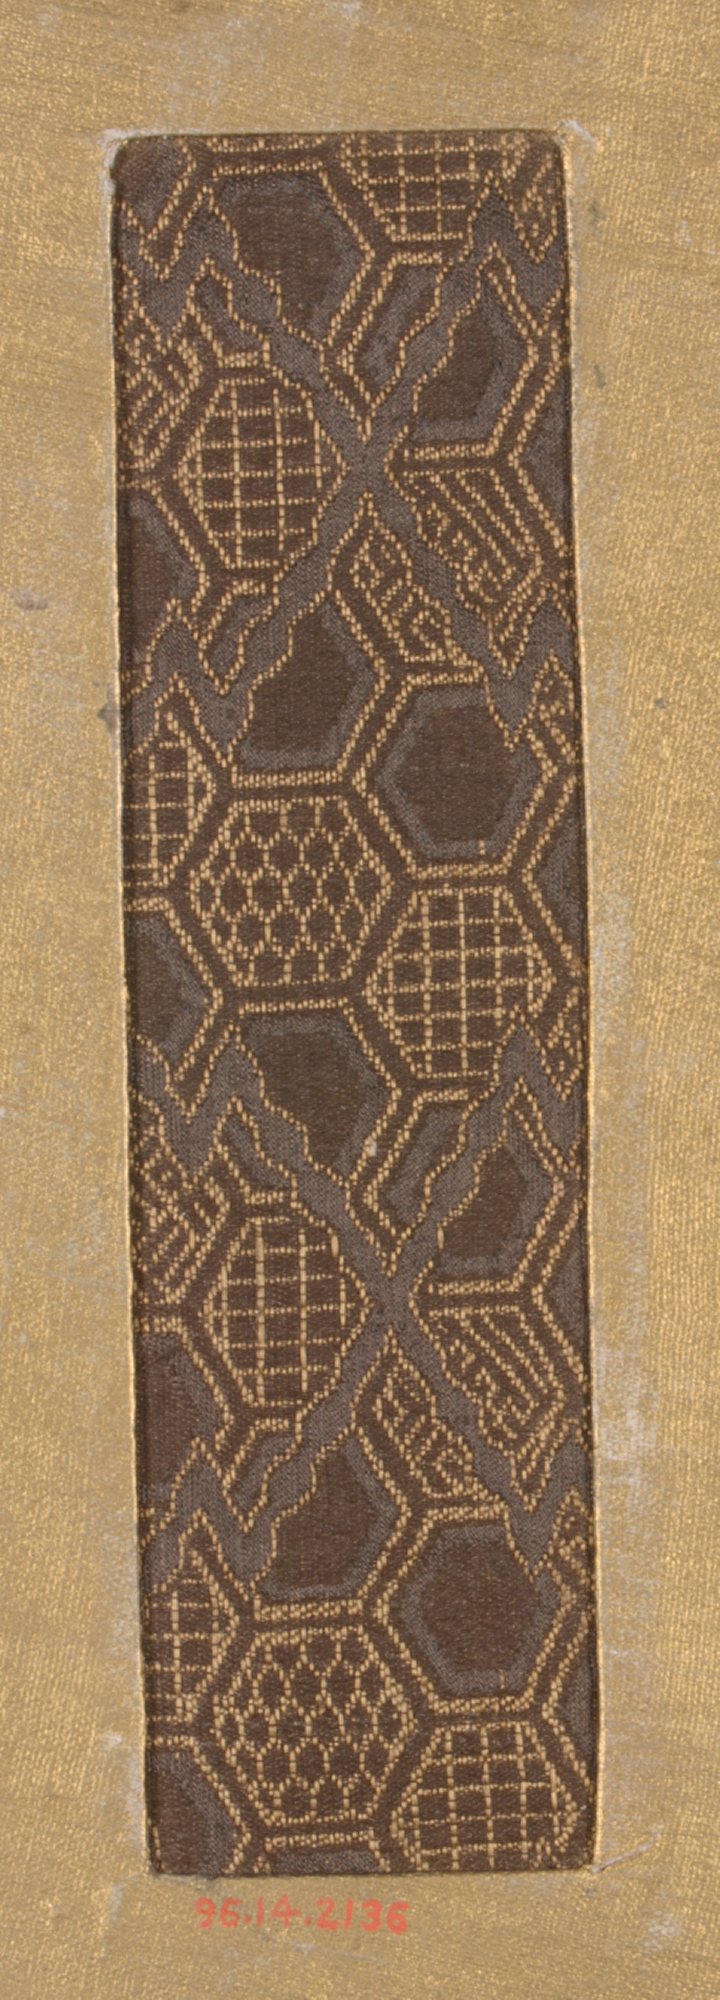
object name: piece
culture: japanese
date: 1701-1900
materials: silk